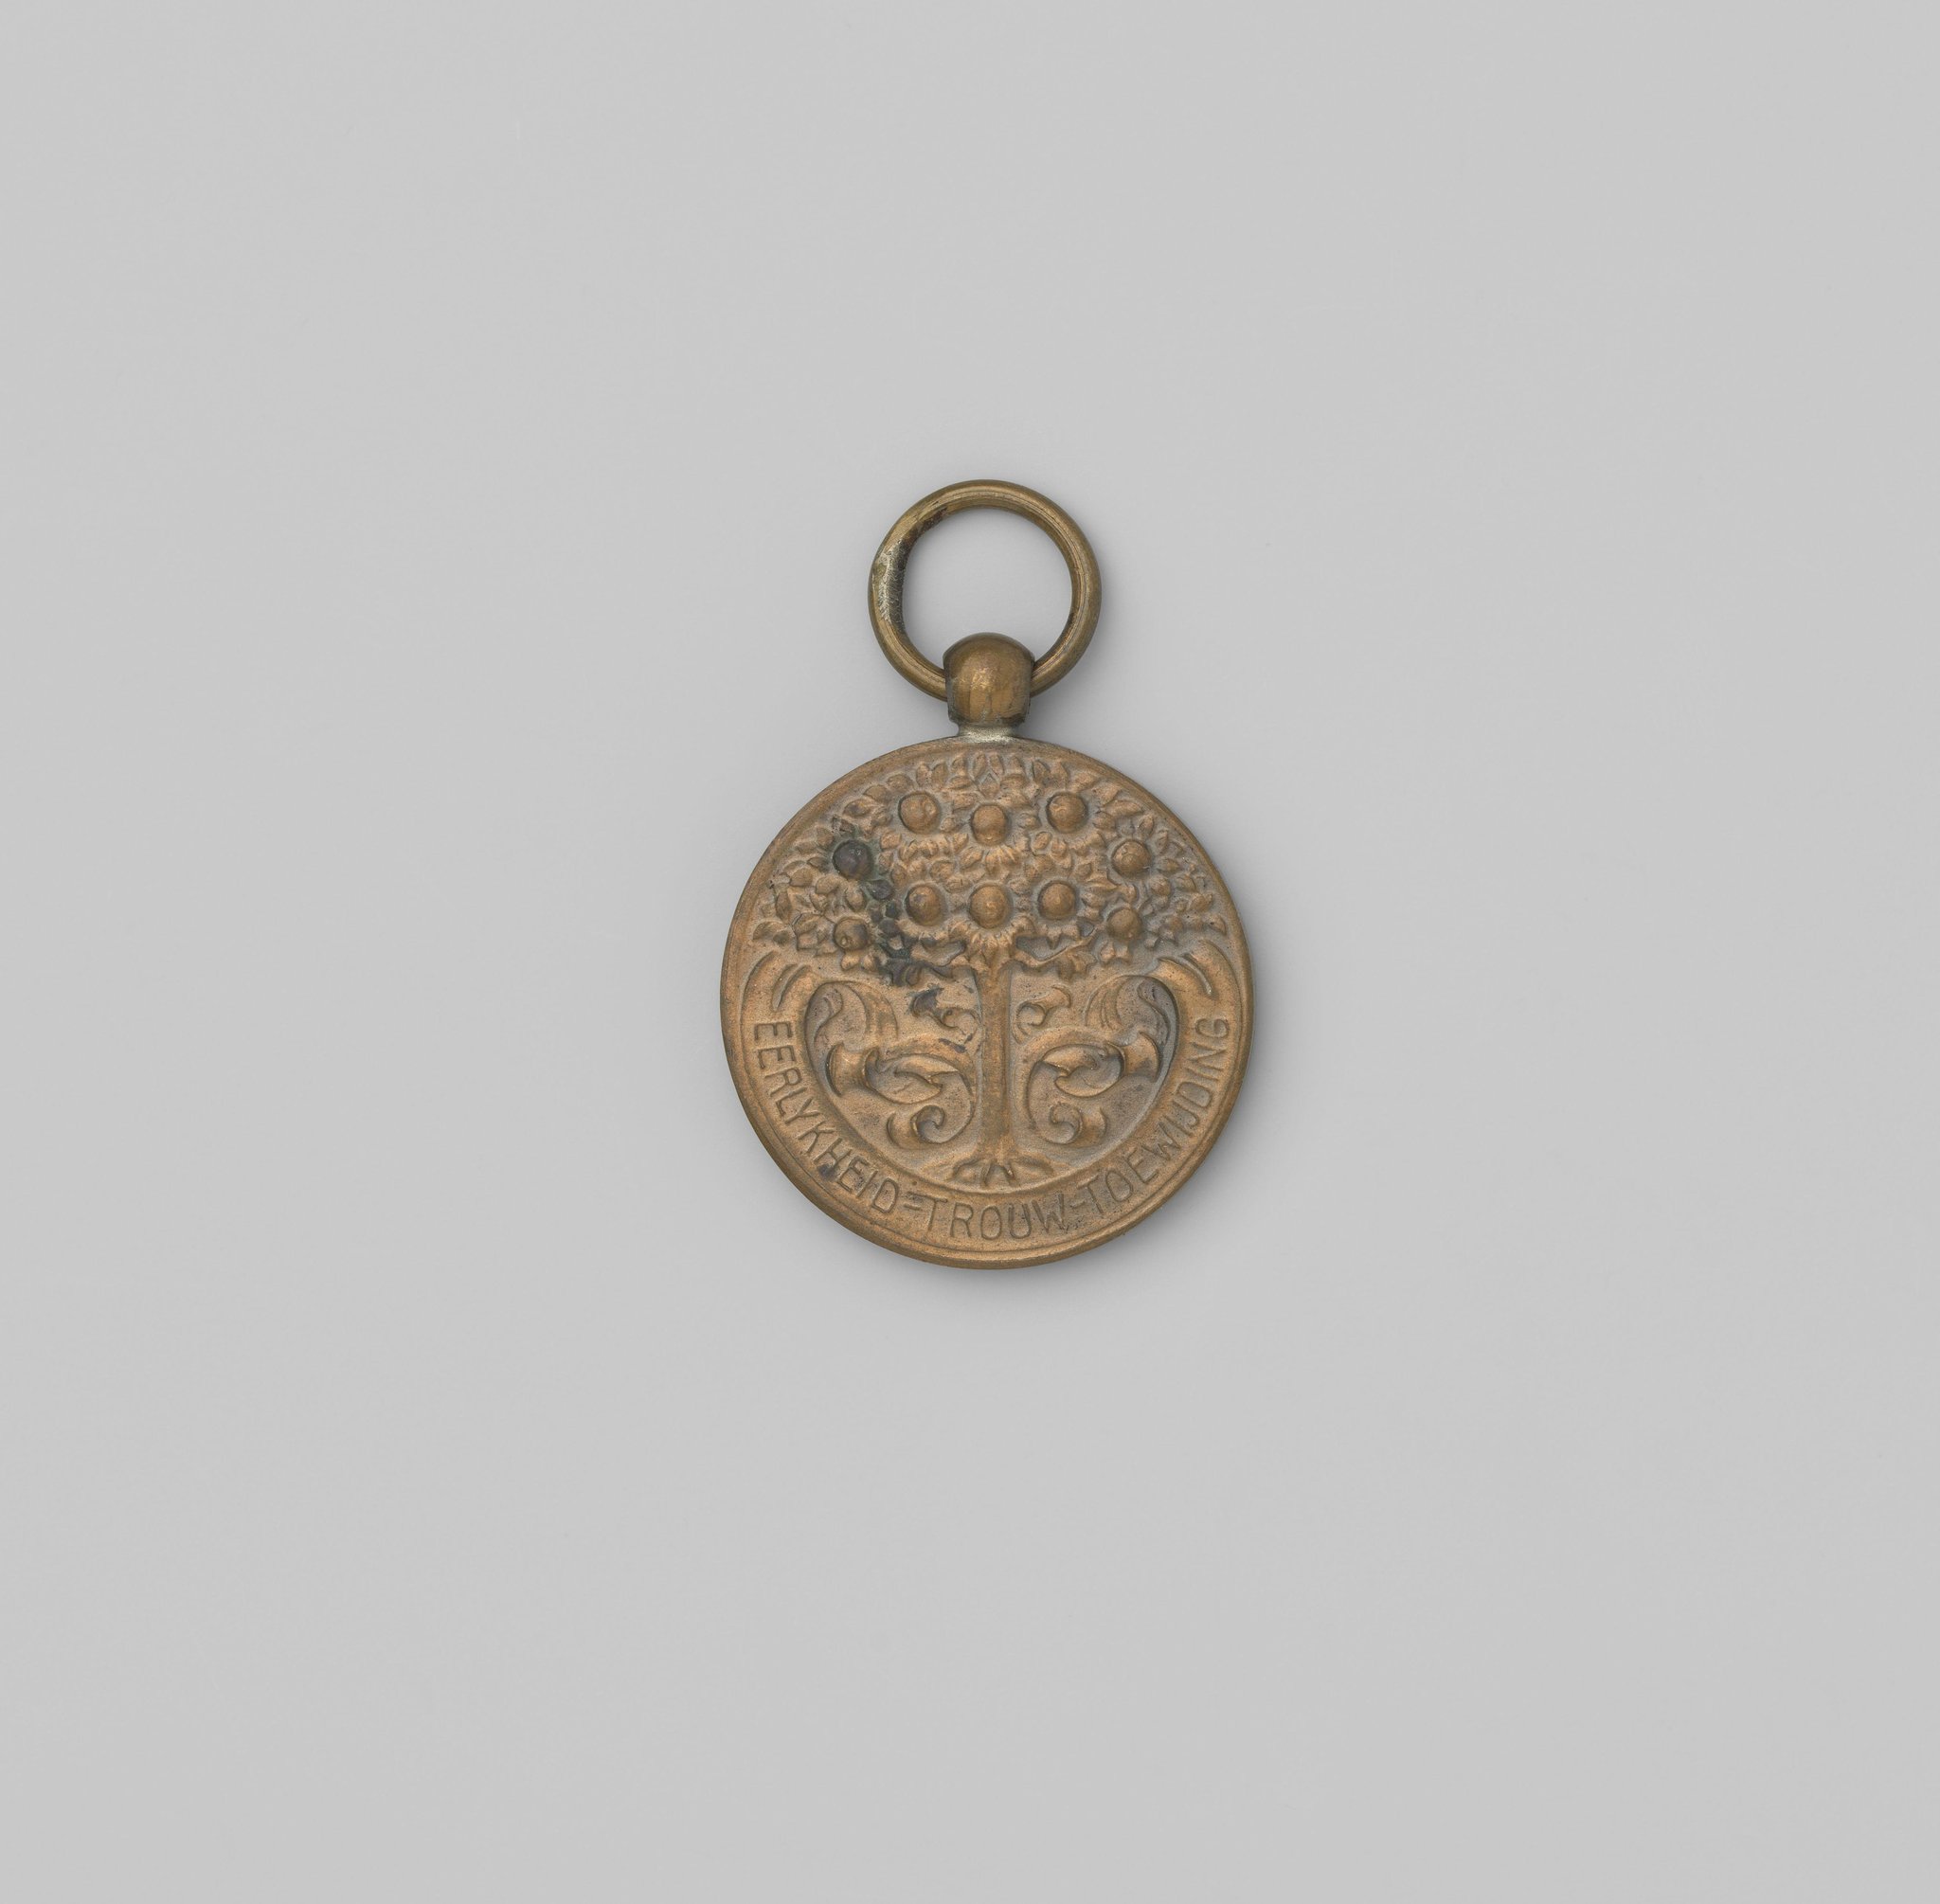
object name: medal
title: Erepenning van de Nederlandsche Vereeniging van Huisvrouwen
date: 1925-1940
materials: bronze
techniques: striking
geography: zeist